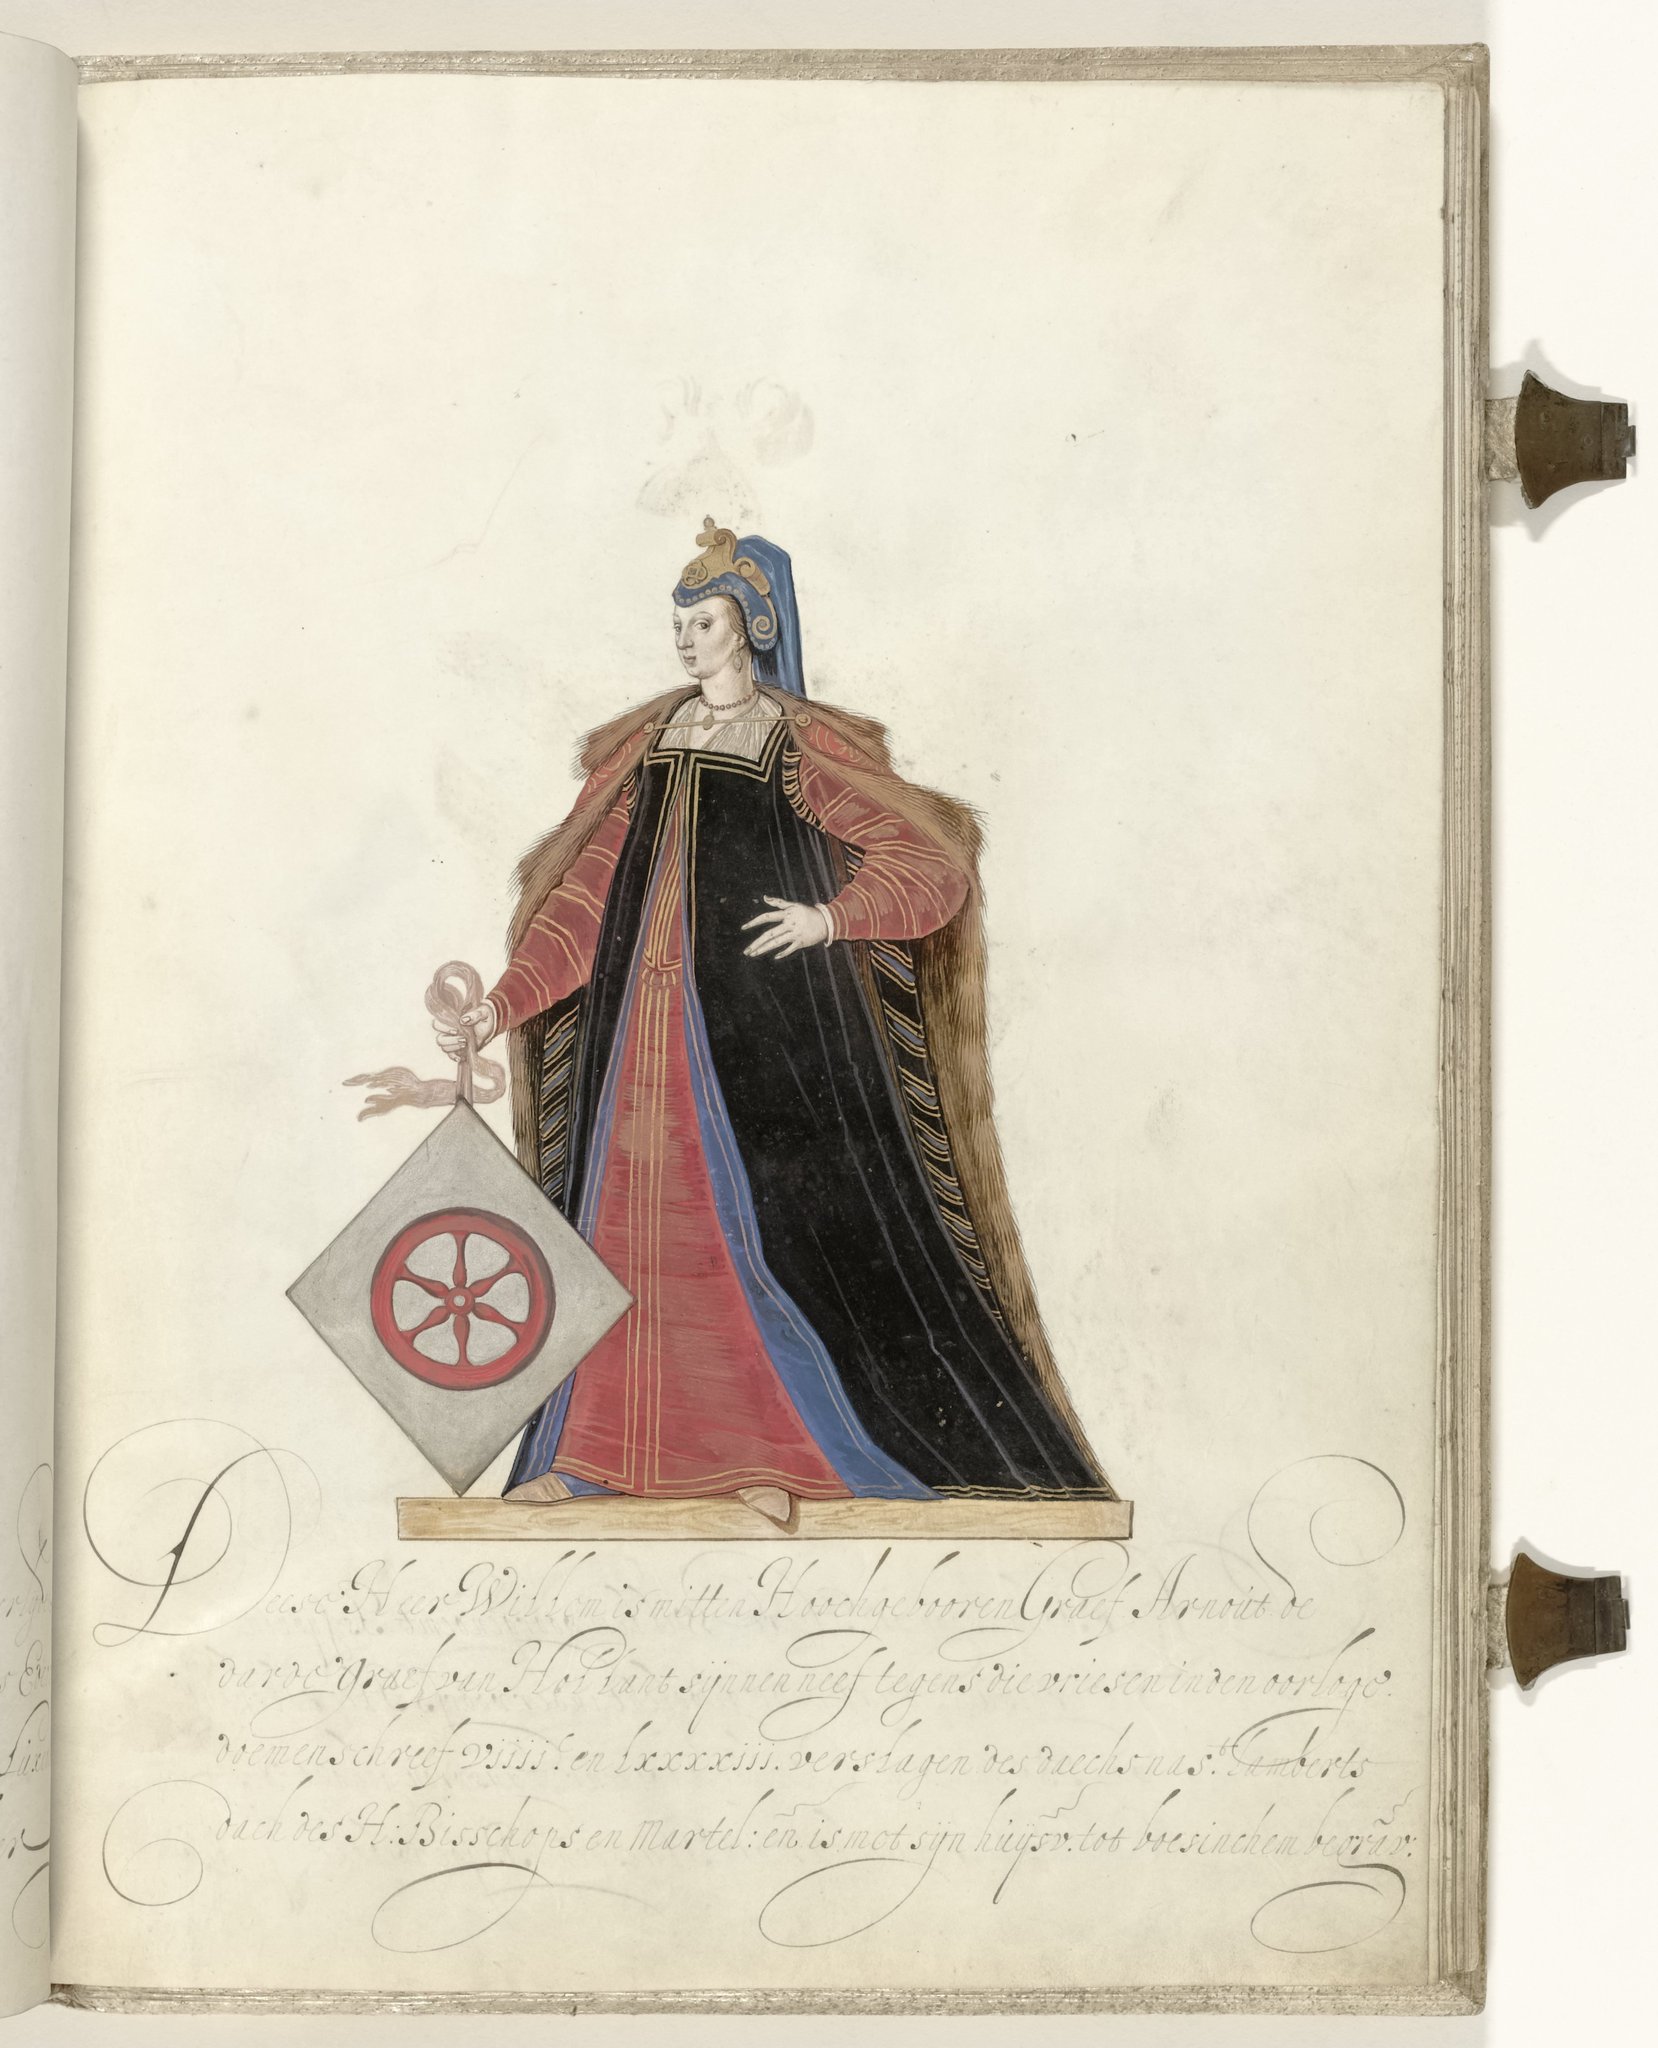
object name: drawing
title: Gravin van Beusichem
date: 1590-1593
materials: paint, gouache, ink, parchment, watercolor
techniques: writing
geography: northern netherlands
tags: culemborg, heren en graven van, heren van beusichem, culemborg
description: Gravin van Beusichem (Boesinchem), echtgenote van graaf Johan van Beusichem. Zij was dochter van de heer van Heusden. Staande ten voeten uit met in de rechterhand het wapen van Heusden. Onderdeel van een geïllustreerd handschrift met de genealogie van de heren en graven van Culemborg.